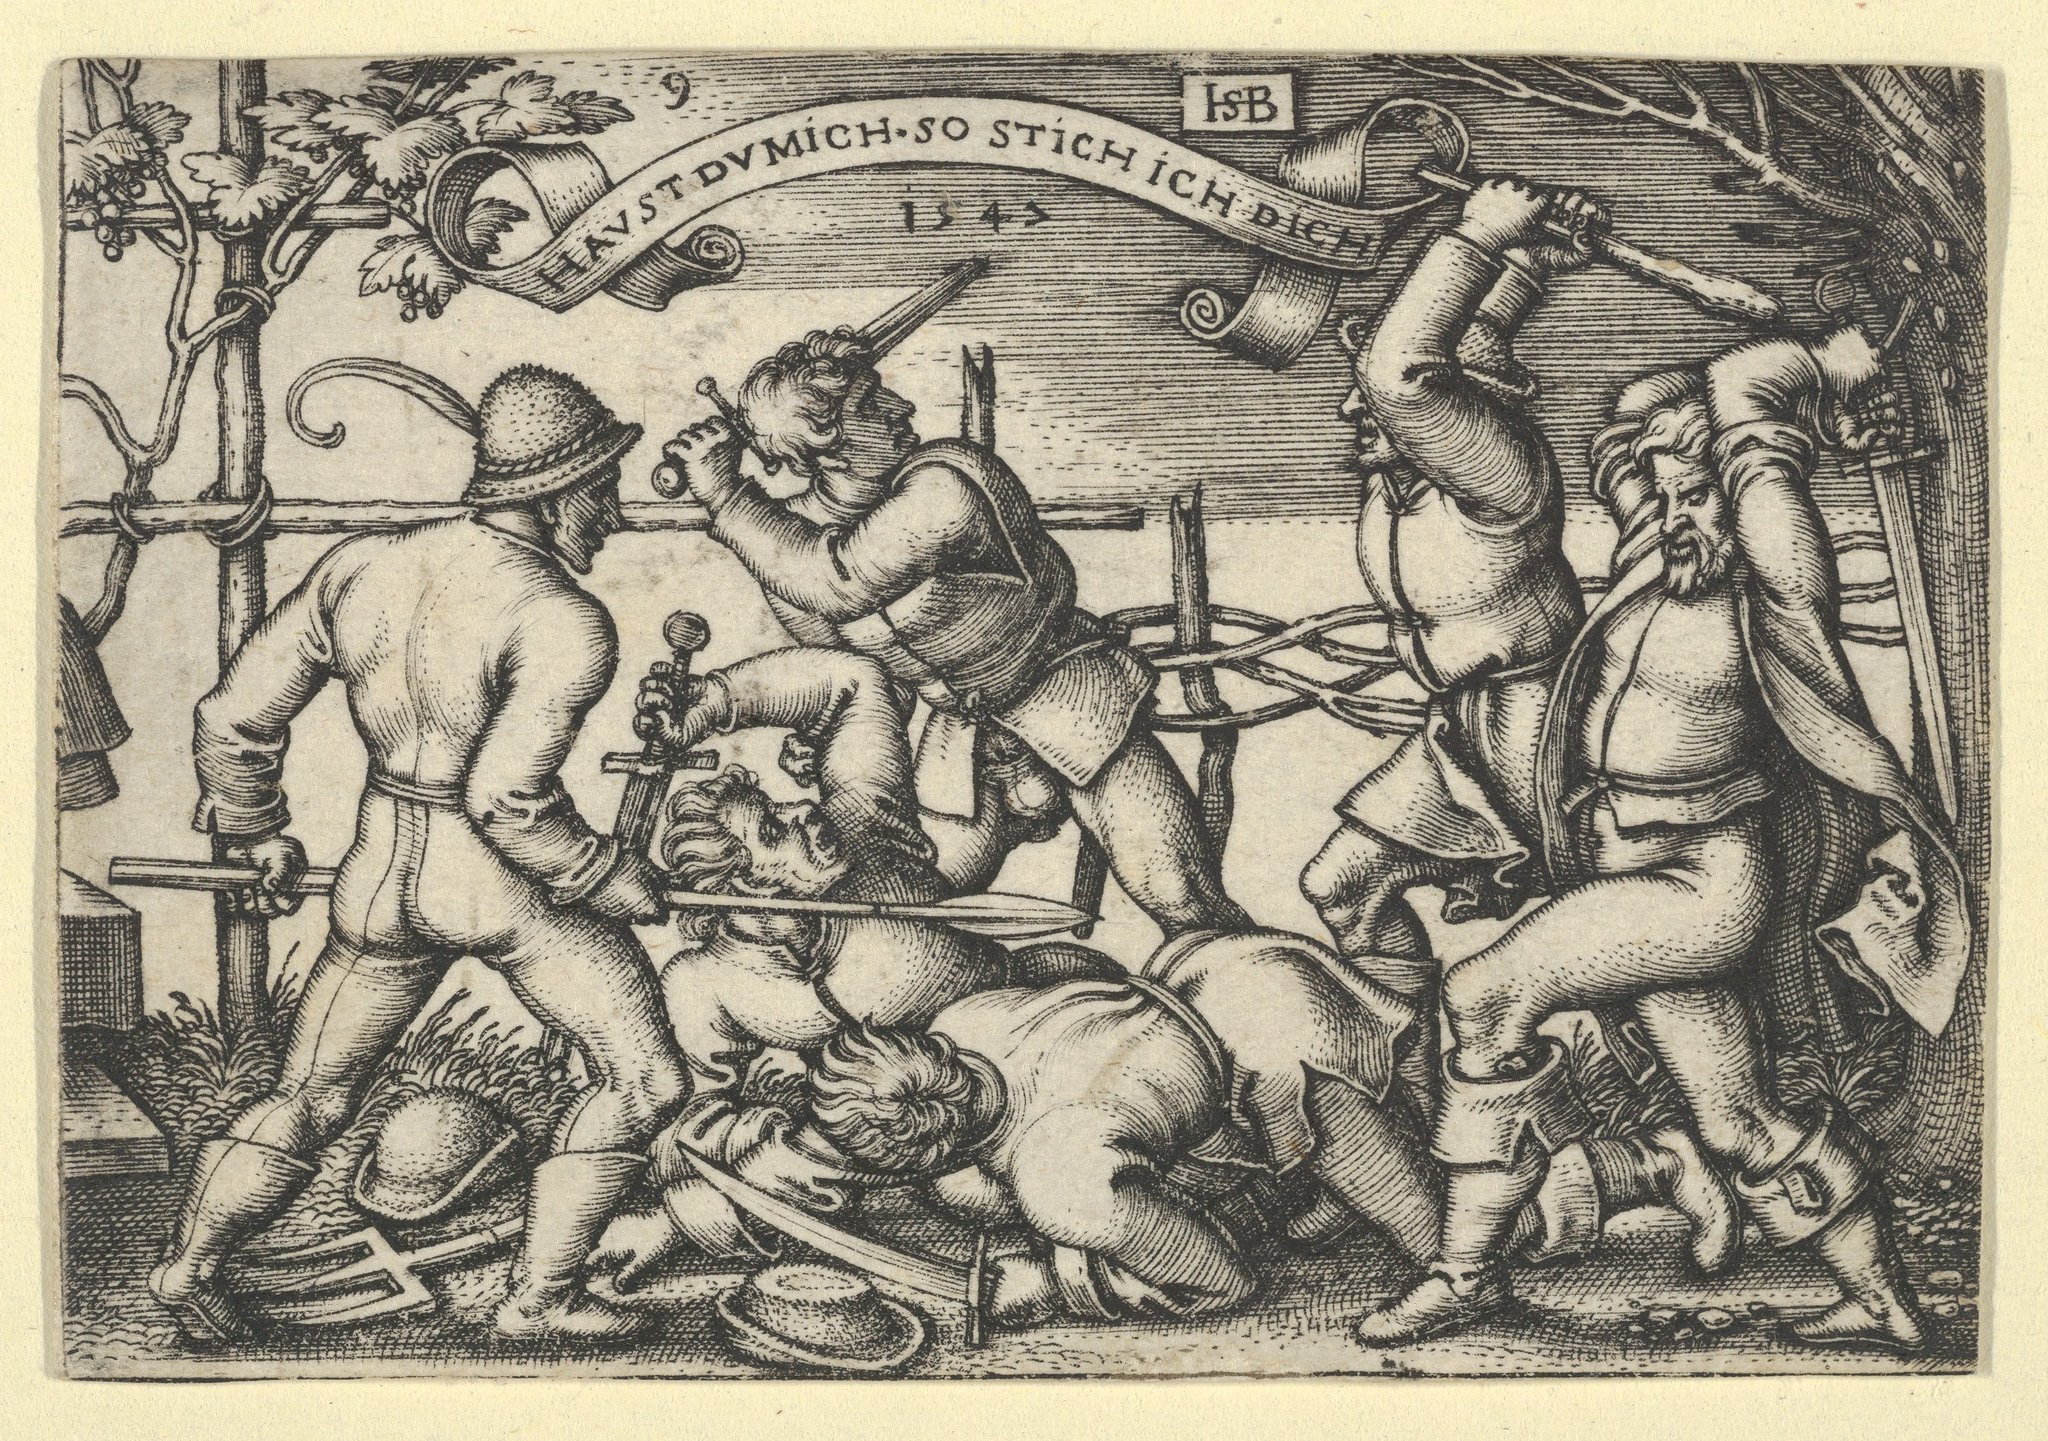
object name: print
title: Peasants' Brawl from "The Peasants' Feast" or "The Twelve Months"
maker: sebald beham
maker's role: artist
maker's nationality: german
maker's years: 1500-1550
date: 1547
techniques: engraving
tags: spears,men